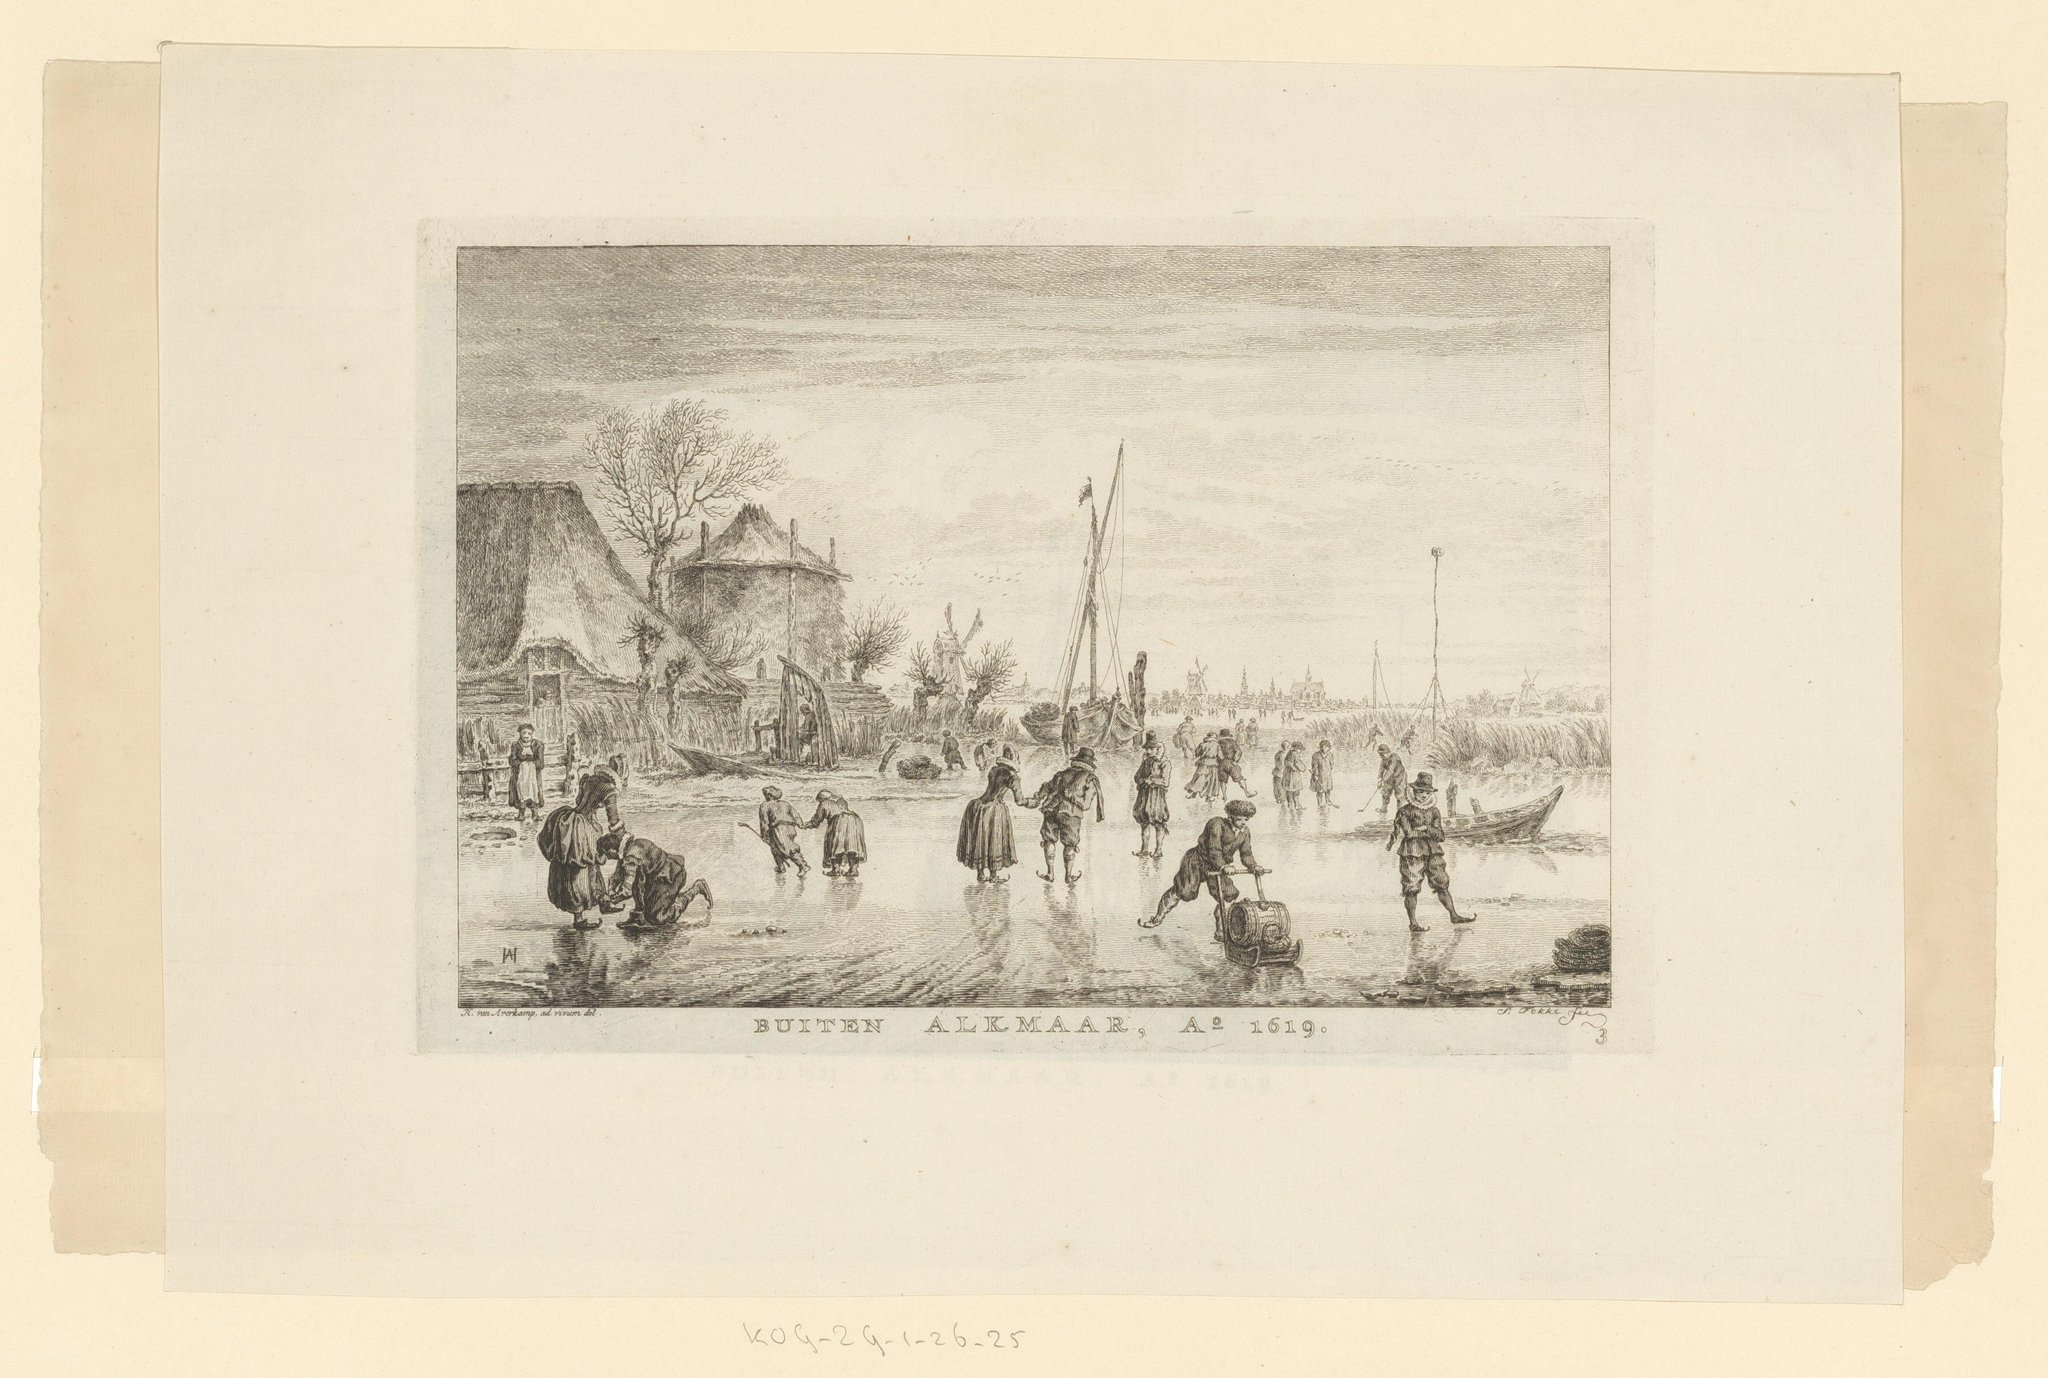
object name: print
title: Noord-Hollandse landschappen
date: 1722-1784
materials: paper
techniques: etching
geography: amsterdam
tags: skates (winter sports), 'kolf' on the ice, severe winters, with chair on ice - cc - adult(s) ~ snow and ice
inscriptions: collector's mark, collector's mark: Lugt 1641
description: IJsvermaak nabij Alkmaar. Op het ijs bevinden zich schaatsende figuren en kolfspelers. In de verte de stad Alkmaar. Genummerd rechtsonder: 3. Onderwerpsrubrieken binnen de Atlas Zeden en Gewoonten: Spel en Vermaak; IJsvermaak, Riviergezichten.